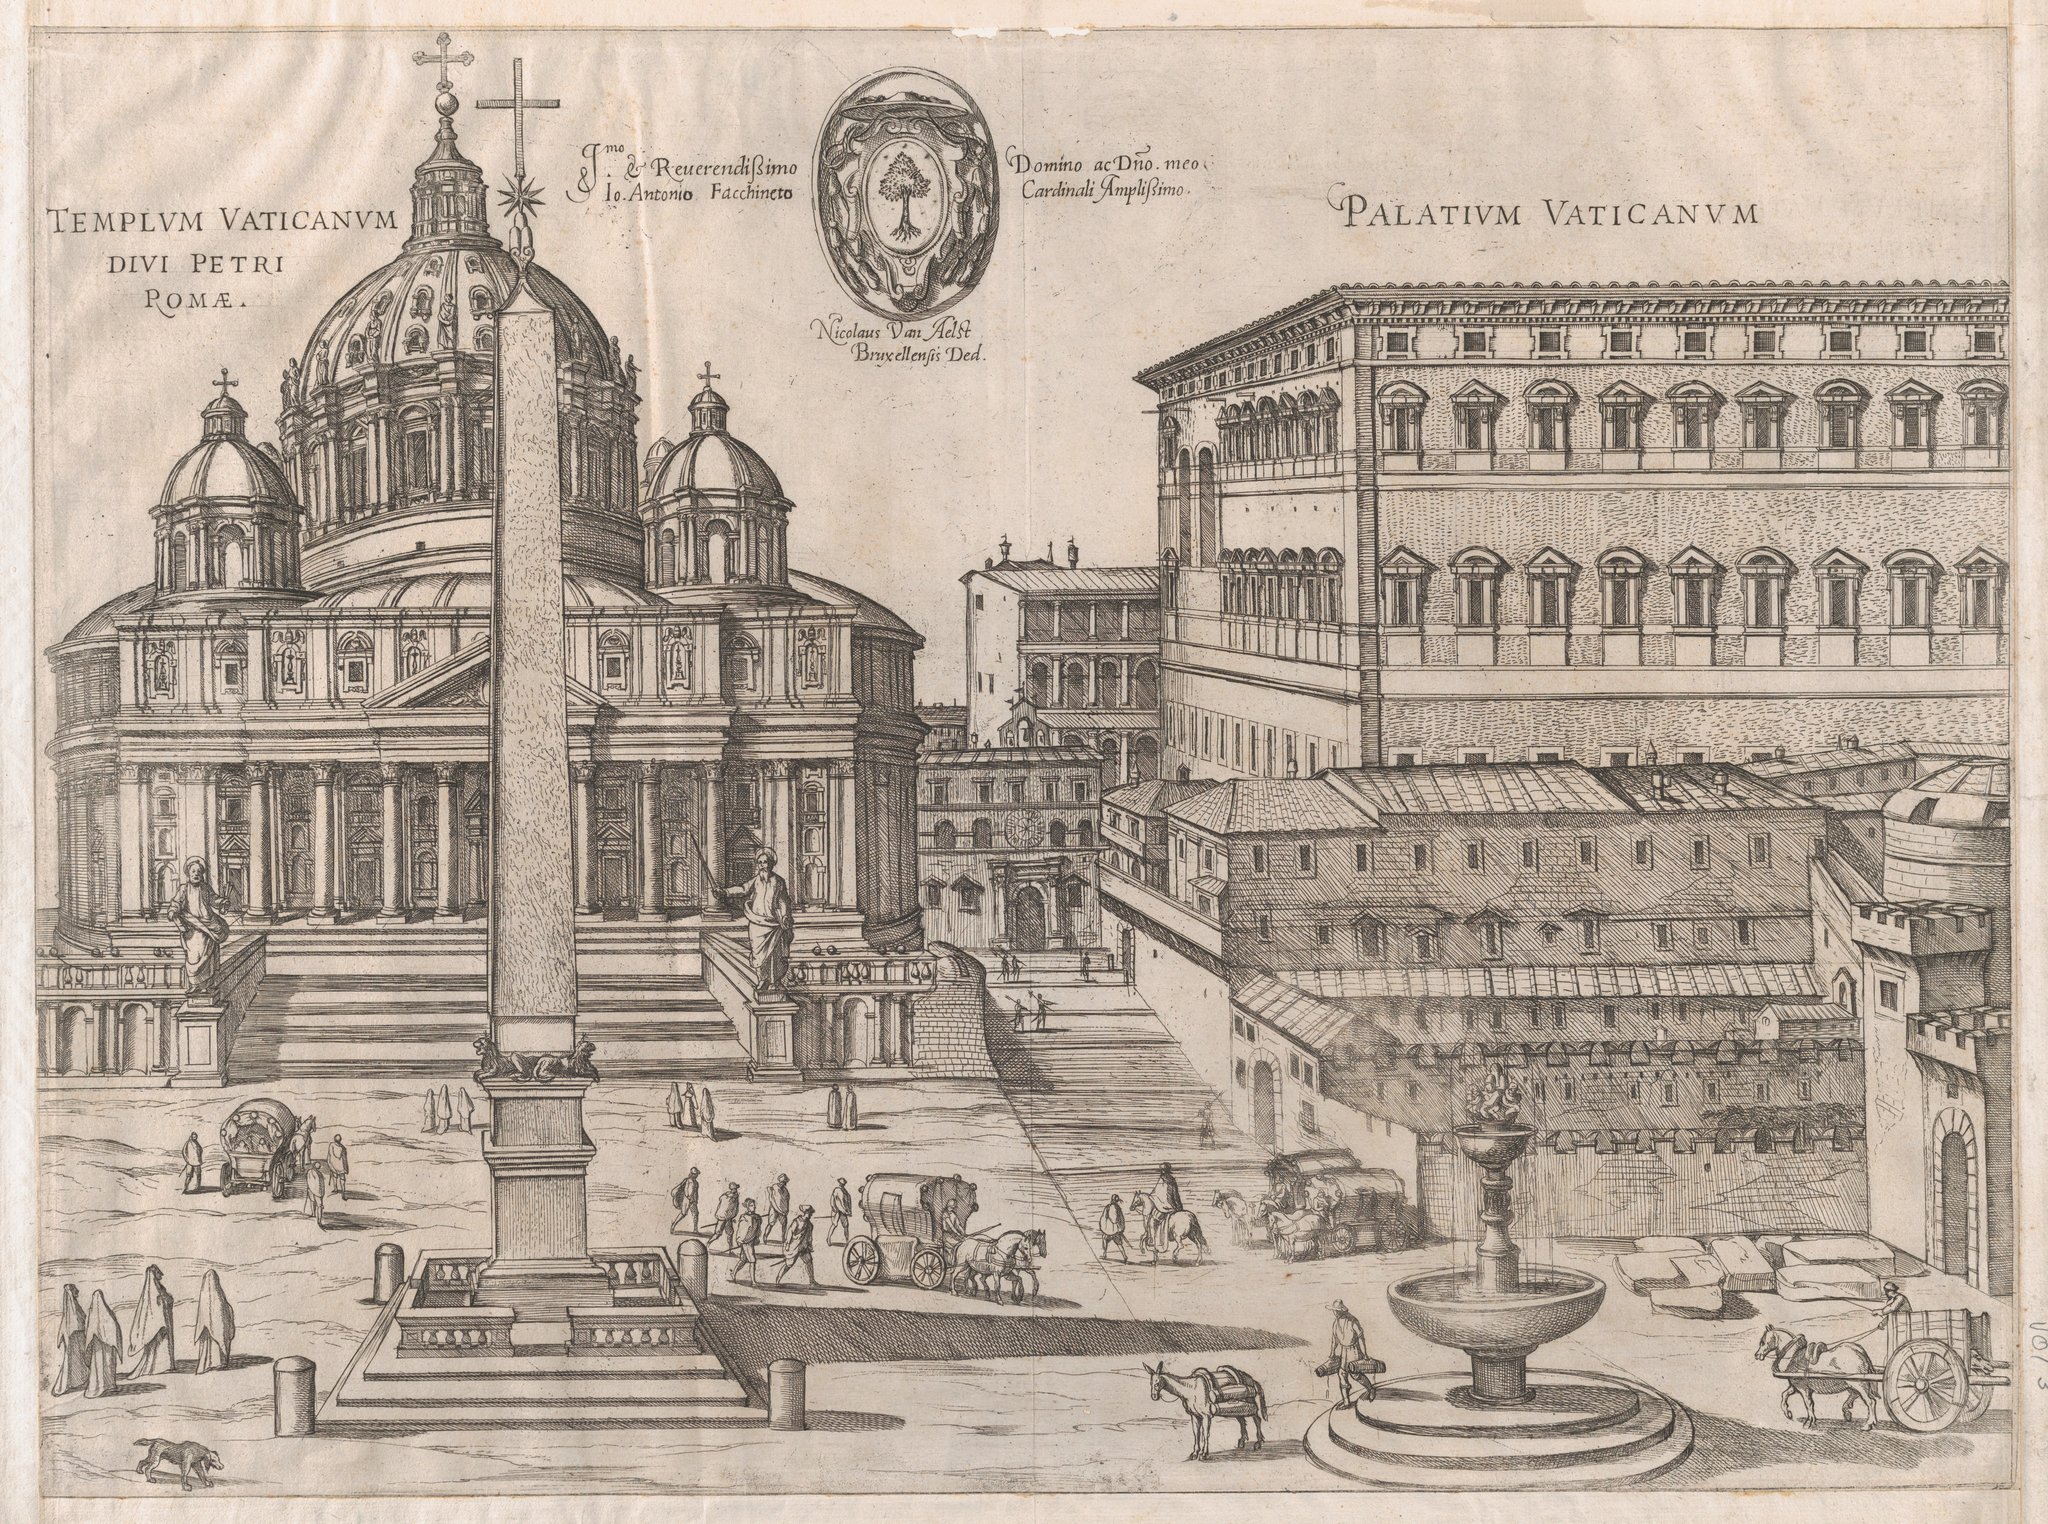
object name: print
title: St. Peter's, from "Speculum Romanae Magnificentiae"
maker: Anonymous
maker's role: artist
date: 1501-1600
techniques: engraving, etching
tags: human figures,buildings,fountains,obelisks,rome